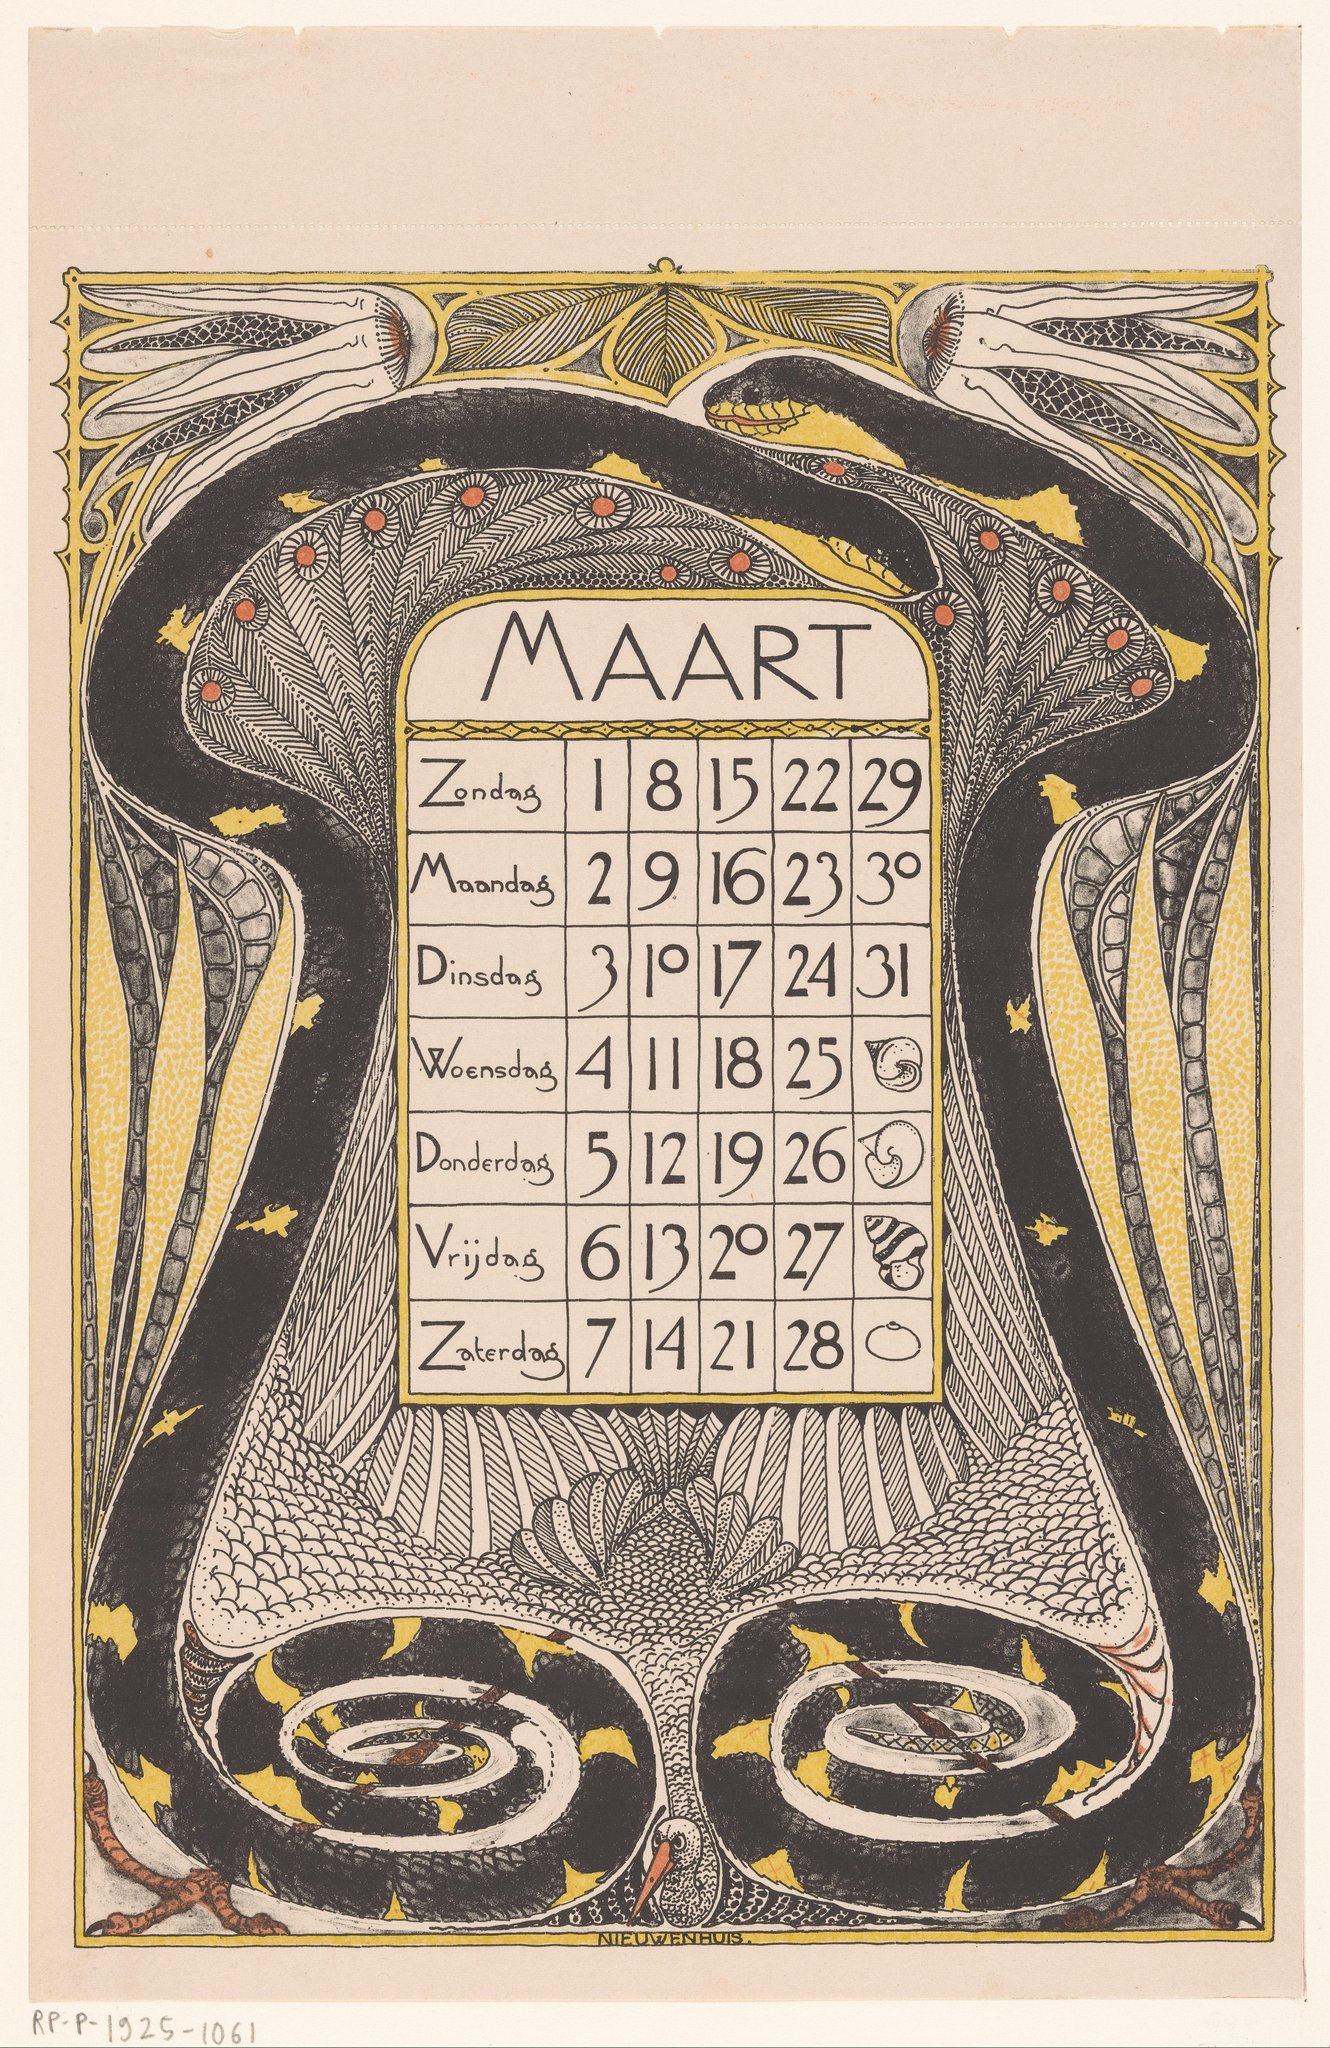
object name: print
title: Kalenderblad voor maart 1896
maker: theo nieuwenhuis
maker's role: designer, draughtsman, print maker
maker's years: 1866-1951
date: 1895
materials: paper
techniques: lithograph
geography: amsterdam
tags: snakes, ornaments ~ art, birds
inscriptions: collector's mark: Lugt 2228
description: Een rechthoekig kader met de dagen van de maand maart en daaromheen een vogel en twee slangen.